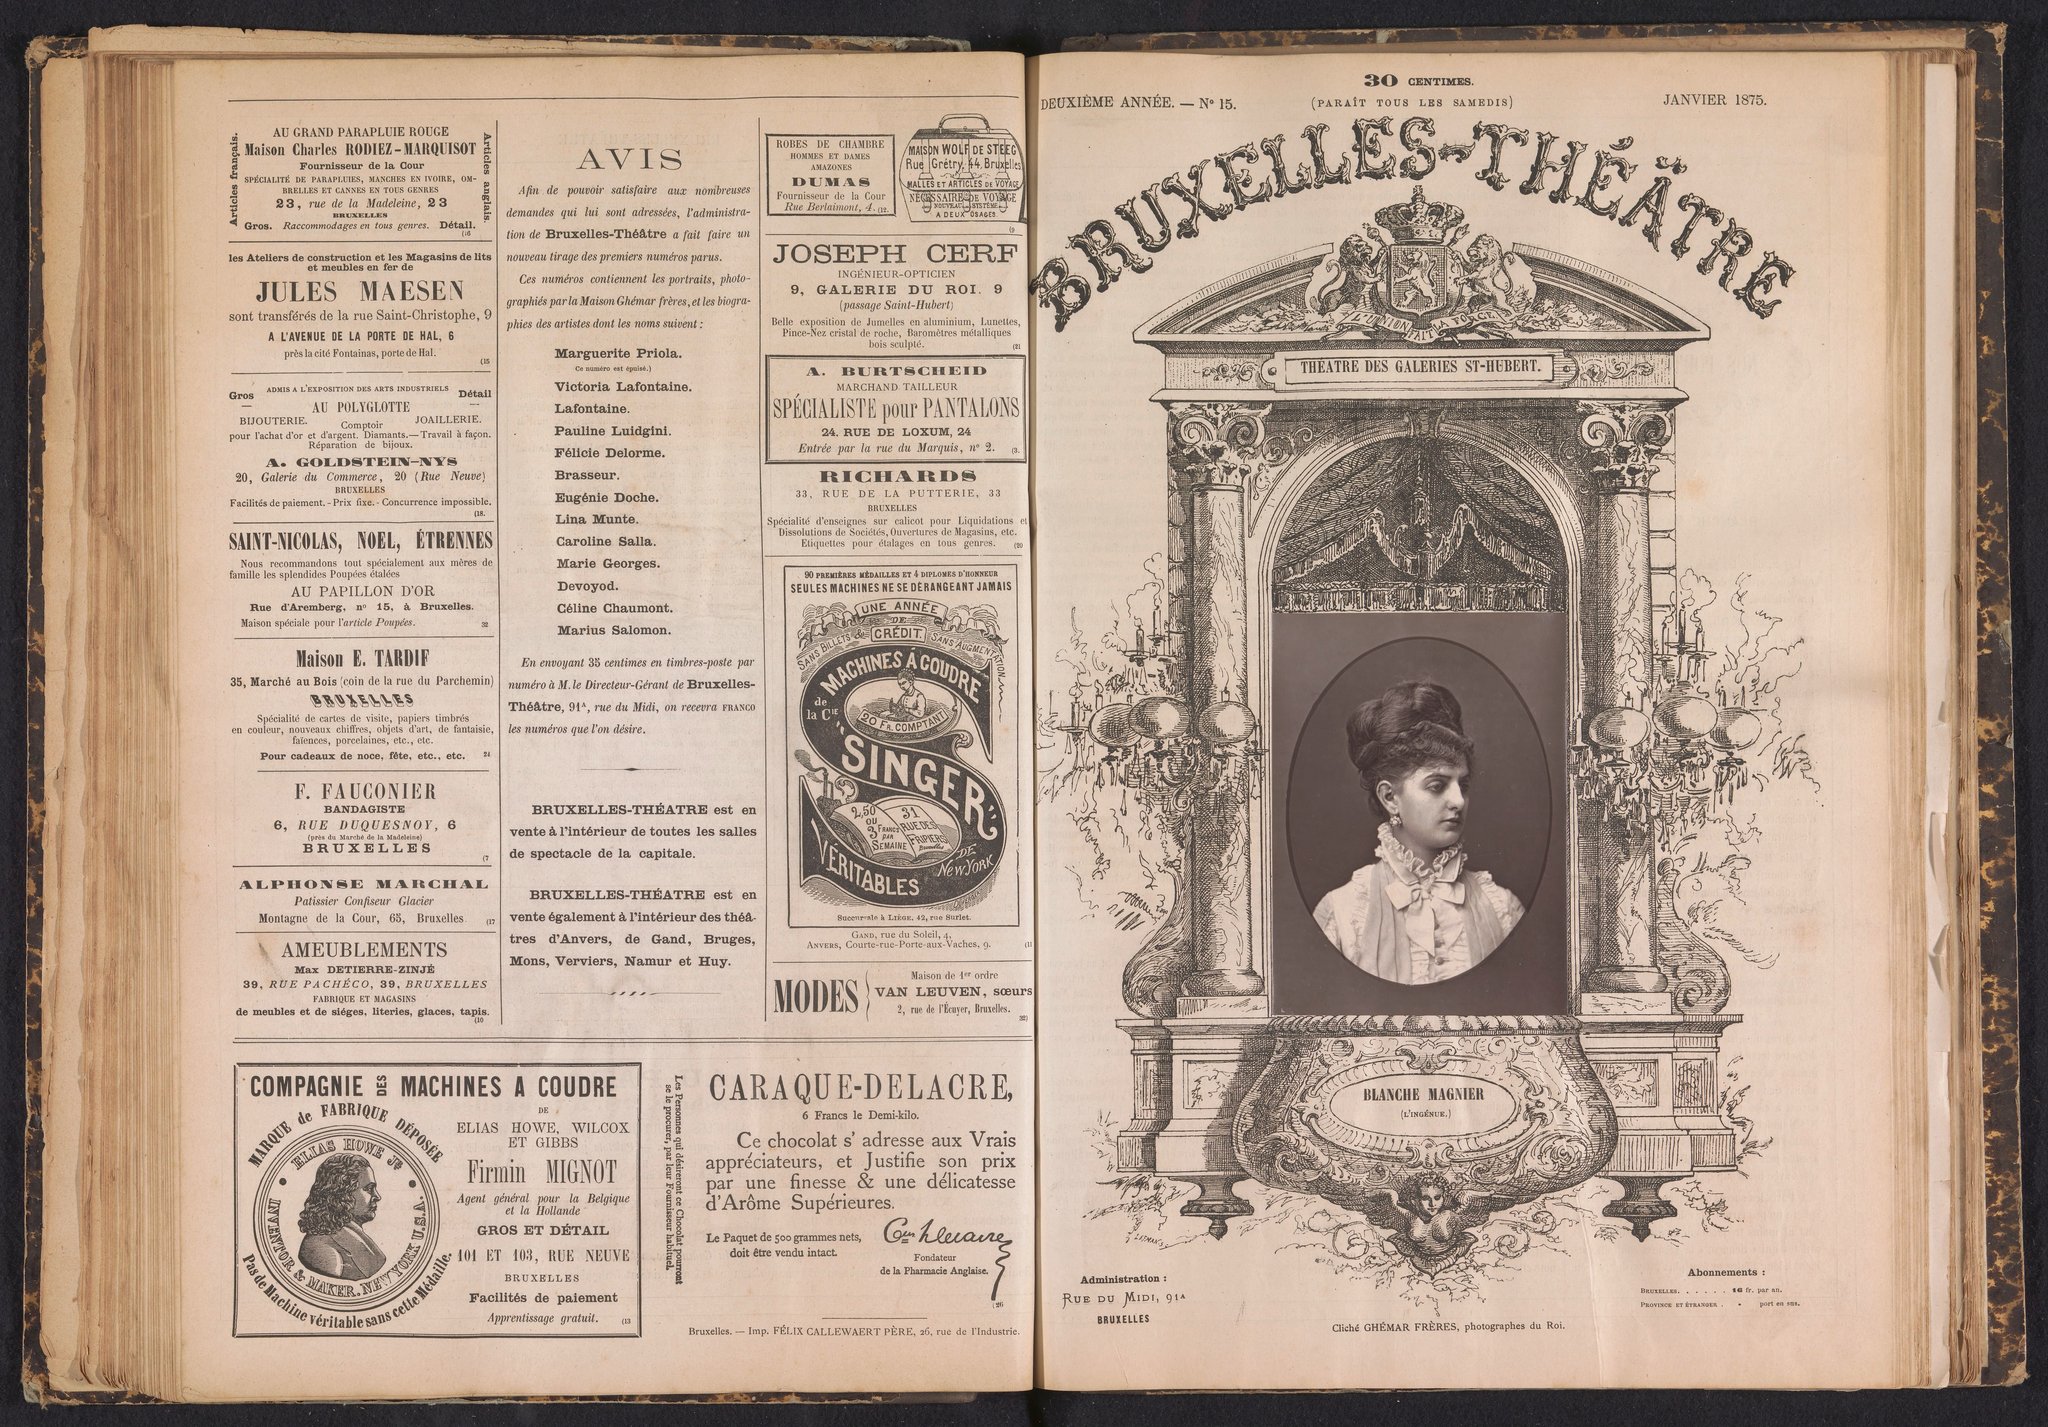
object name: page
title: Blanche Magnier (L'ingénue)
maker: Anonymous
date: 1869-1874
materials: paper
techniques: woodburytype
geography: brussels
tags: portrait of actor, actress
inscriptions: number: ‘No 15.’